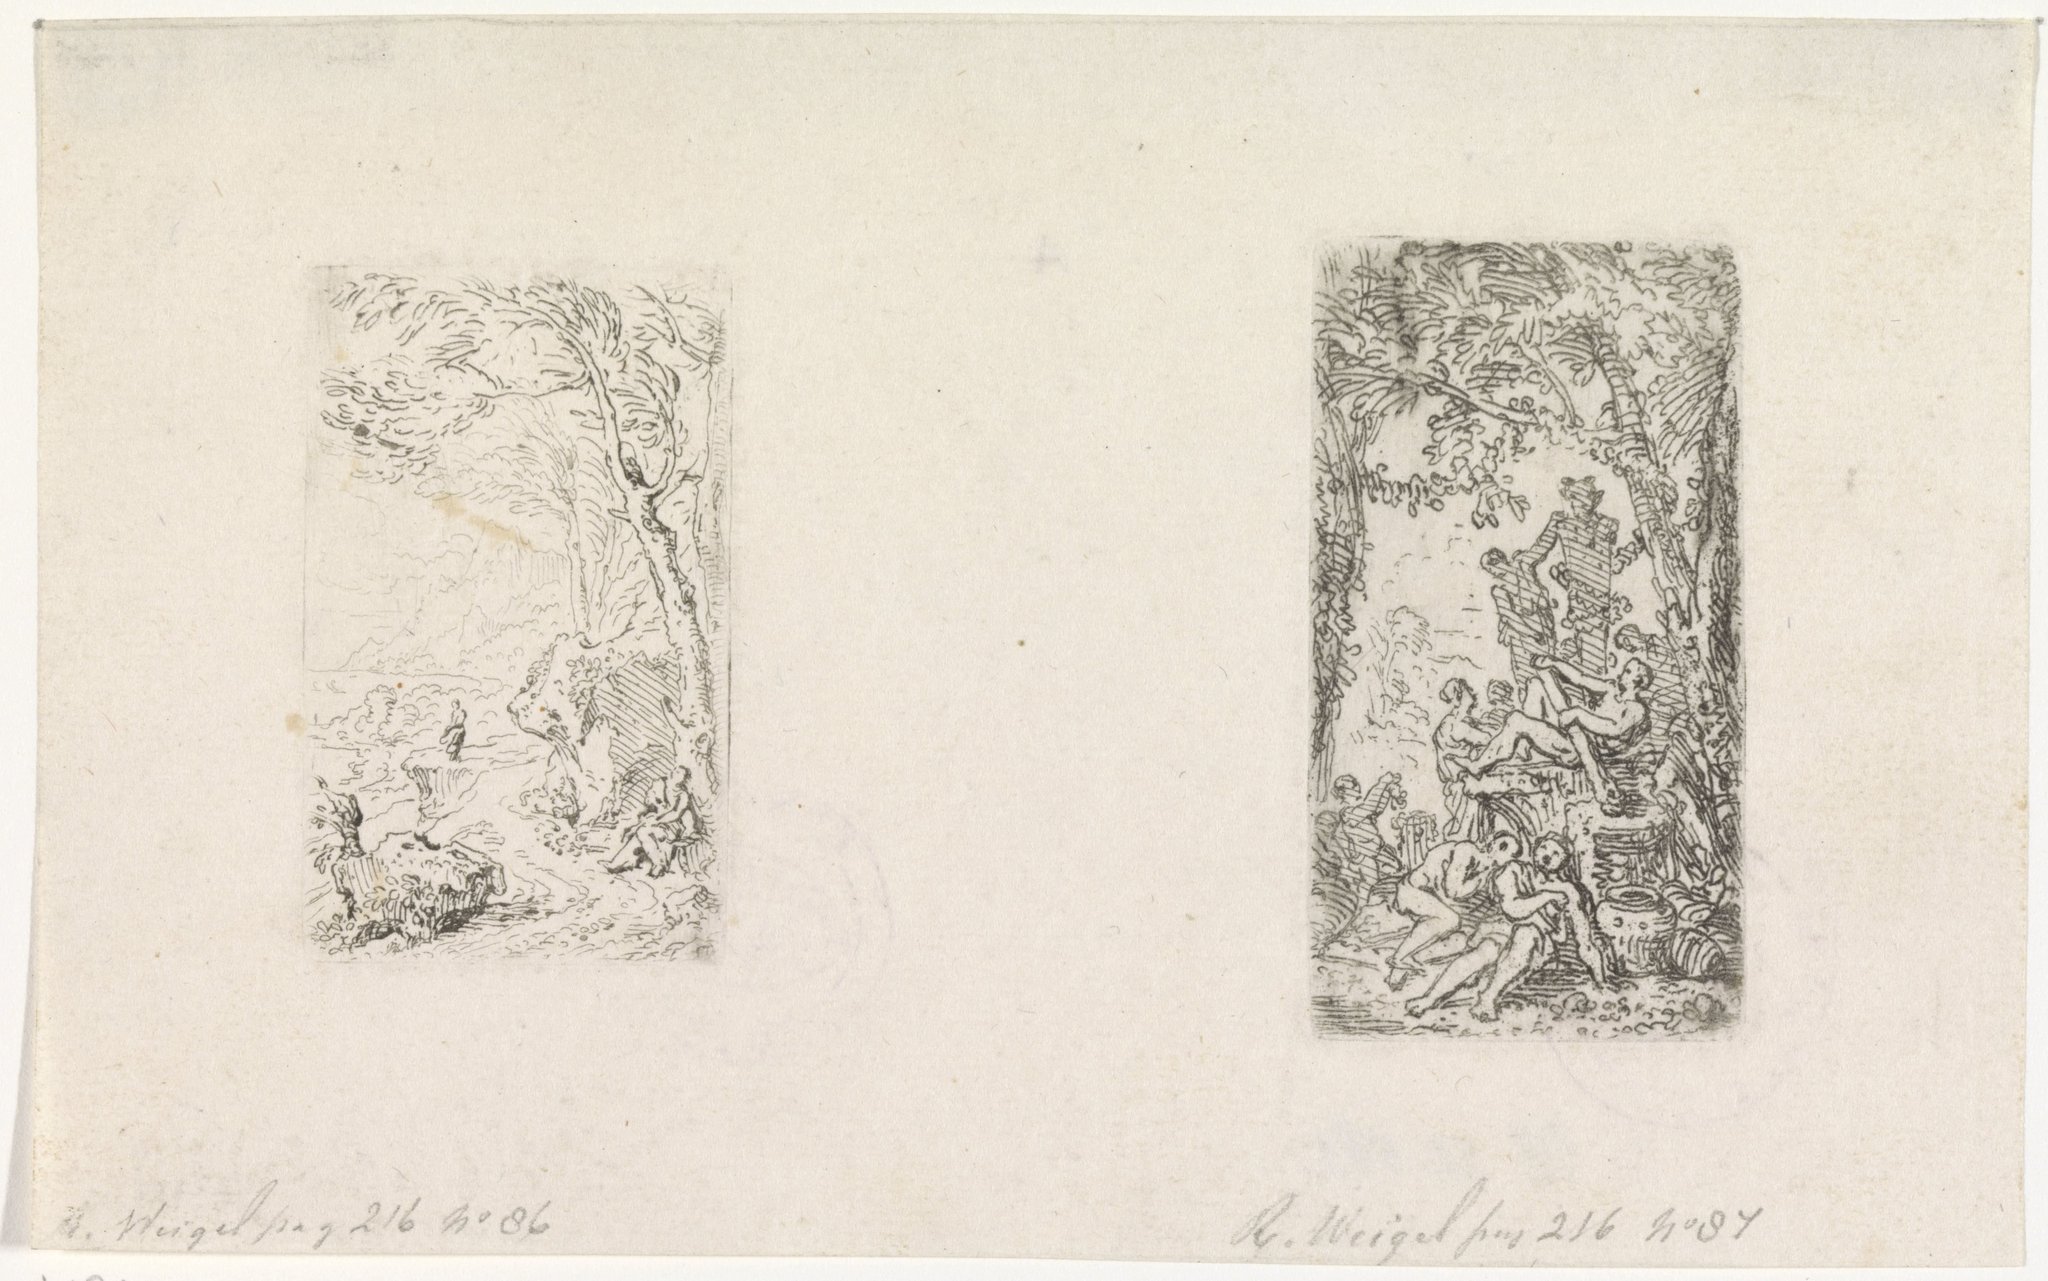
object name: print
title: Twee voorstellingen: een landschap en een bacchanaal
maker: abraham genoels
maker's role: draughtsman, print maker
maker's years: 1640-1723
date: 1650-1723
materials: paper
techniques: etching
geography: paris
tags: thiasos, i.e. bacchus' revel-rout, bacchanal without bacchus, public road (+ city(-scape) with figures, staffage)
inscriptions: collector's mark: Lugt 240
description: Links een landschap met een weg. Rechts een bacchanaal.